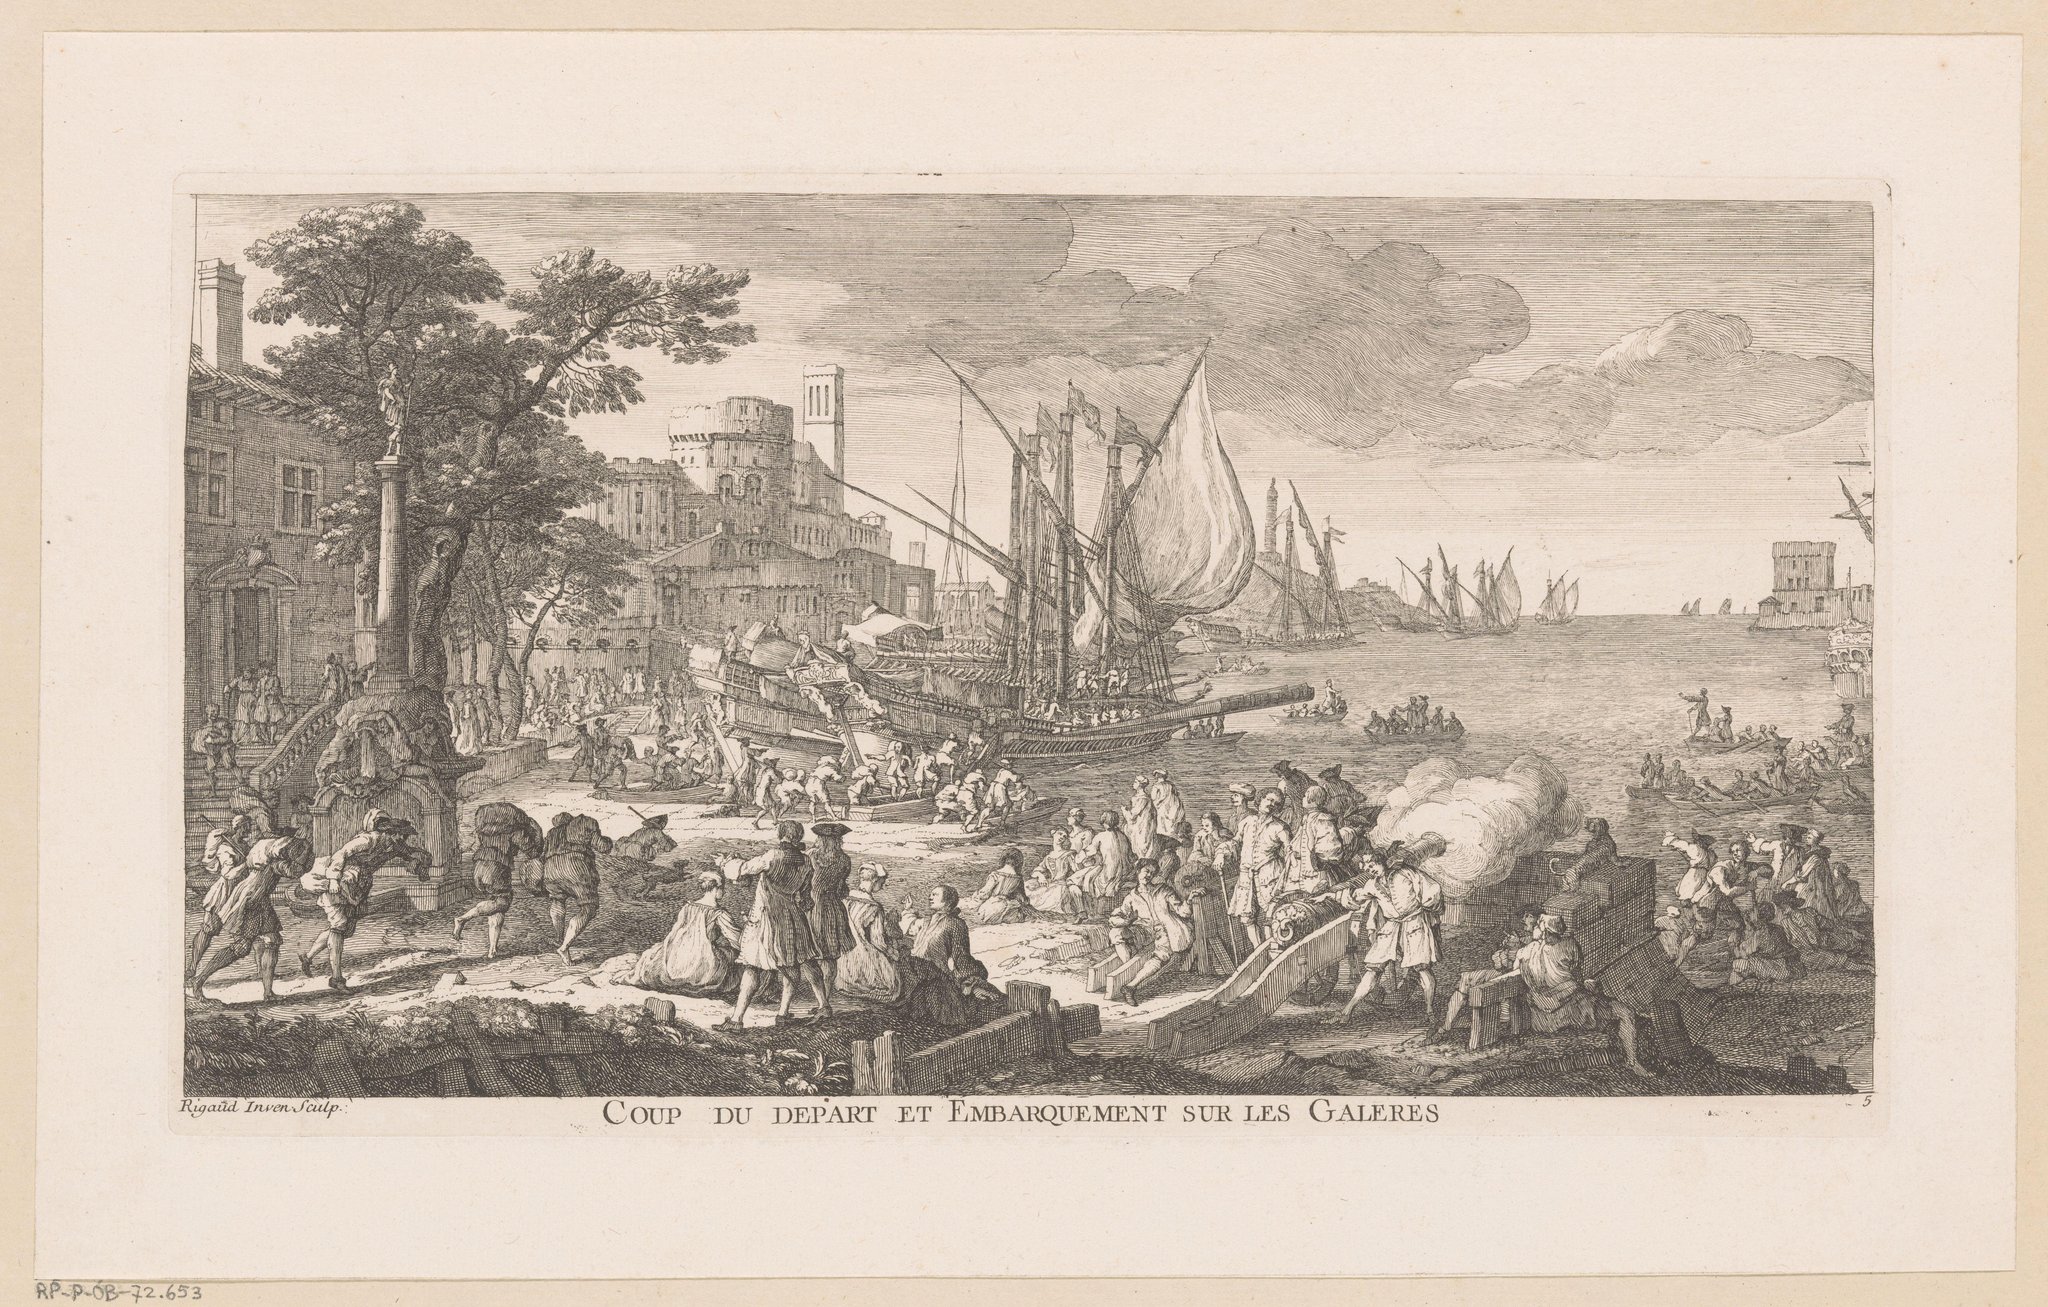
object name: print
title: Diverse fases in de constructie van een galeischip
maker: jacques rigaud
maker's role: draughtsman, painter, print maker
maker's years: 1681-1754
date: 1720-1754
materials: paper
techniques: engraving, etching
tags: shipyard, shipdock, trireme, galley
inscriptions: collector's mark: Lugt 240